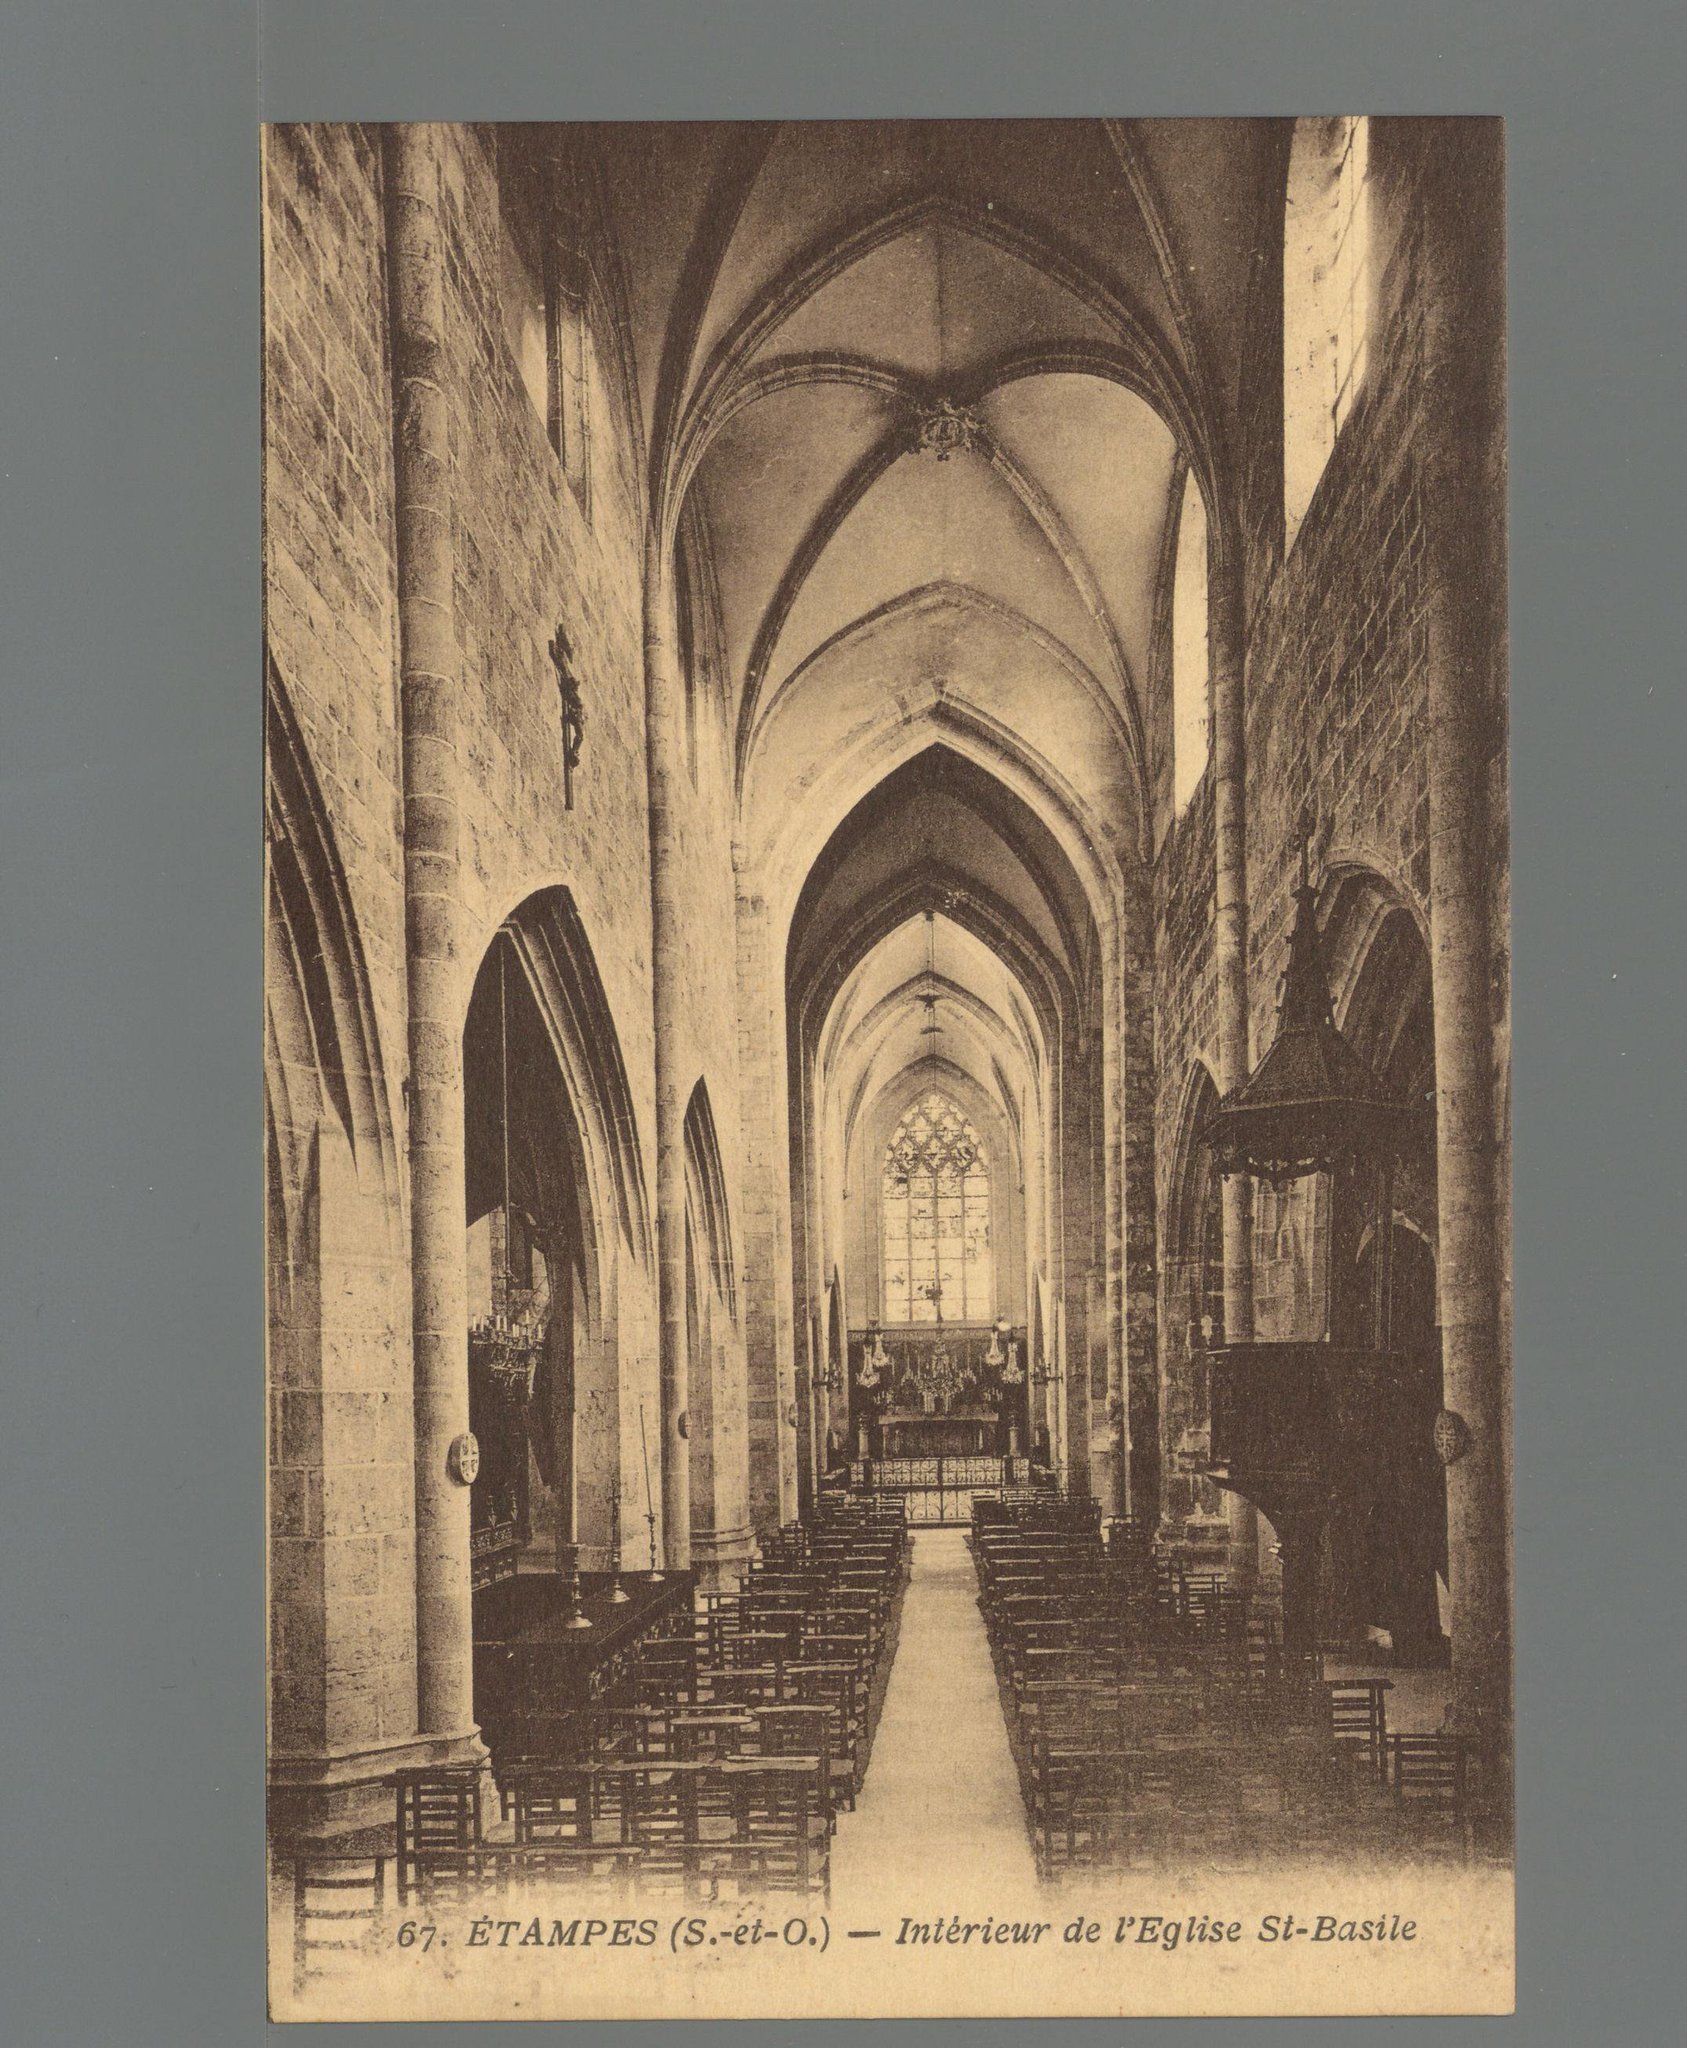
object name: photomechanical print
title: Étampes (S.-et-O.) - Intérieur de l'Eglise St-Basile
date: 1903-1930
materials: cardboard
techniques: photograph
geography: etampes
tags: interior of church